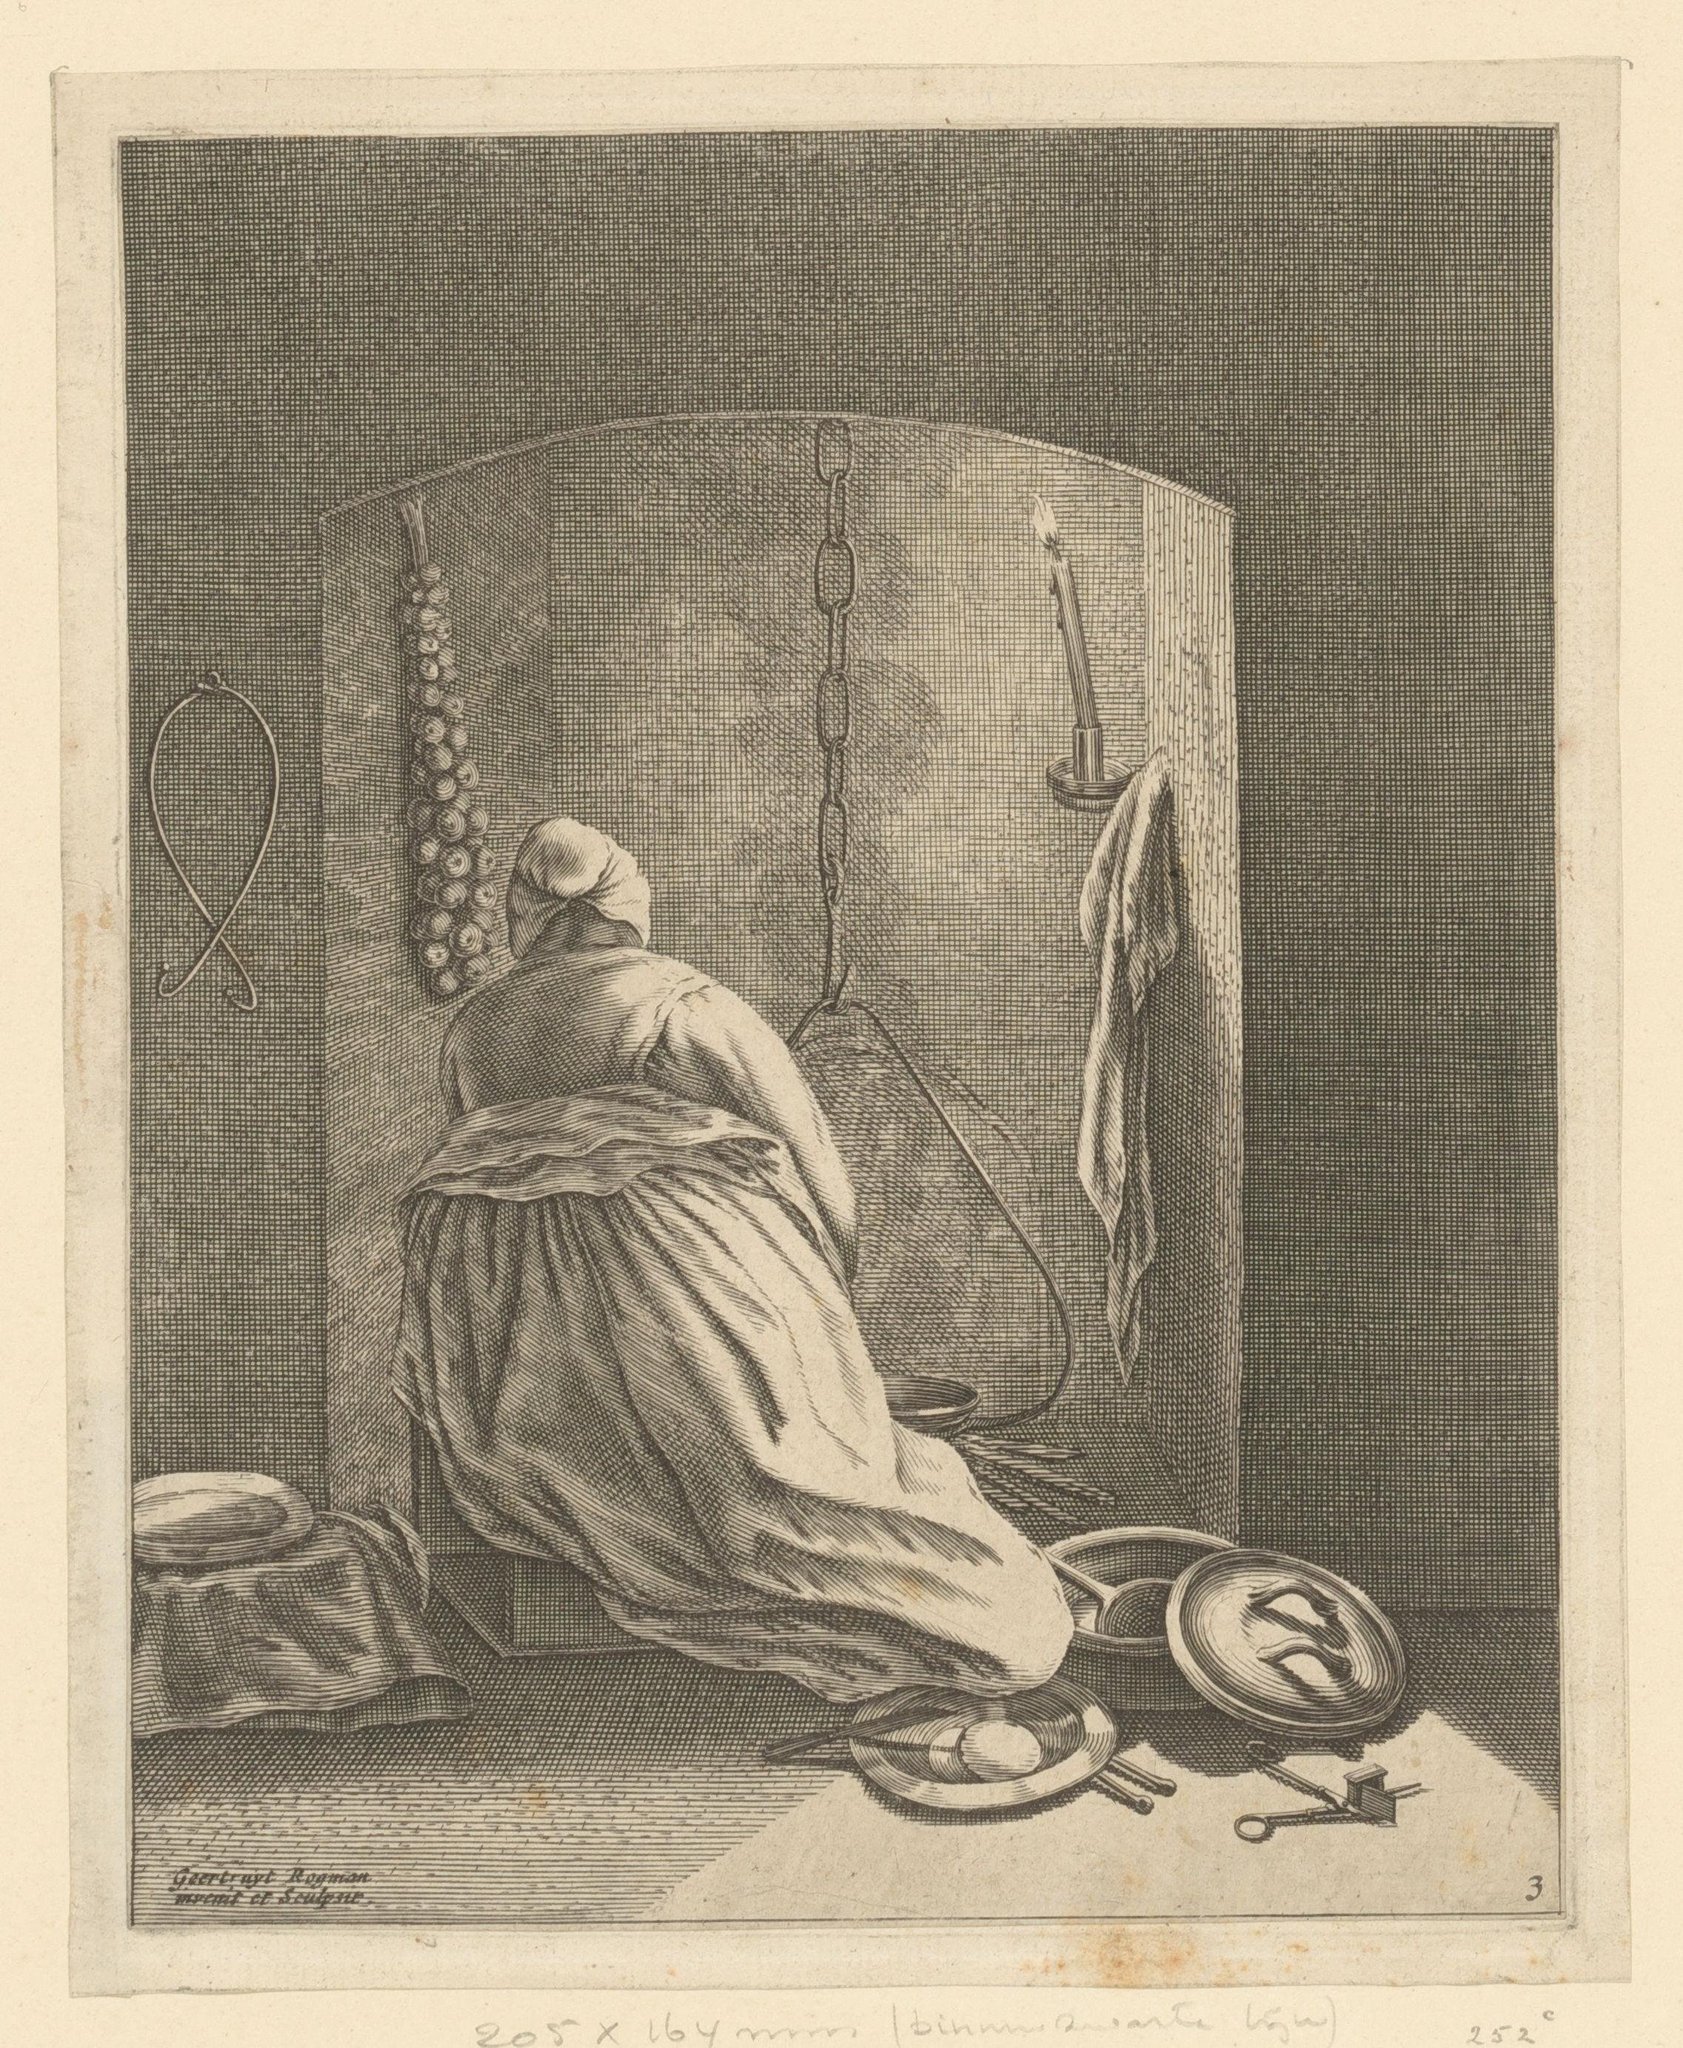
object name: print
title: Huiselijke werkzaamheden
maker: geertruydt roghman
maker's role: print maker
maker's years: 1625-1657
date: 1648-1650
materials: paper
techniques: engraving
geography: netherlands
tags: snuffers, kitchen-utensils, plants and herbs: garlic, candle, cooking food, kitchen-maid, kitchen servant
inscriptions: collector's mark: Lugt 1641, collector's mark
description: Een vrouw, op de rug gezien, zittend op een stoof bij een vuurplaats. Aan een ketting en een hangijzer hangt een pan boven het vuur. Aan de muur en op de grond divers keukengerei. Rechtsonder genummerd: 3. De prent maakt deel uit van een serie van vijf prenten met huiselijke werkzaamheden. Onderwerpsrubrieken binnen de Atlas Zeden en Gewoonten: Beroep en bedrijf. Vrouwelijk beroep en bedrijf. Dienstboden.